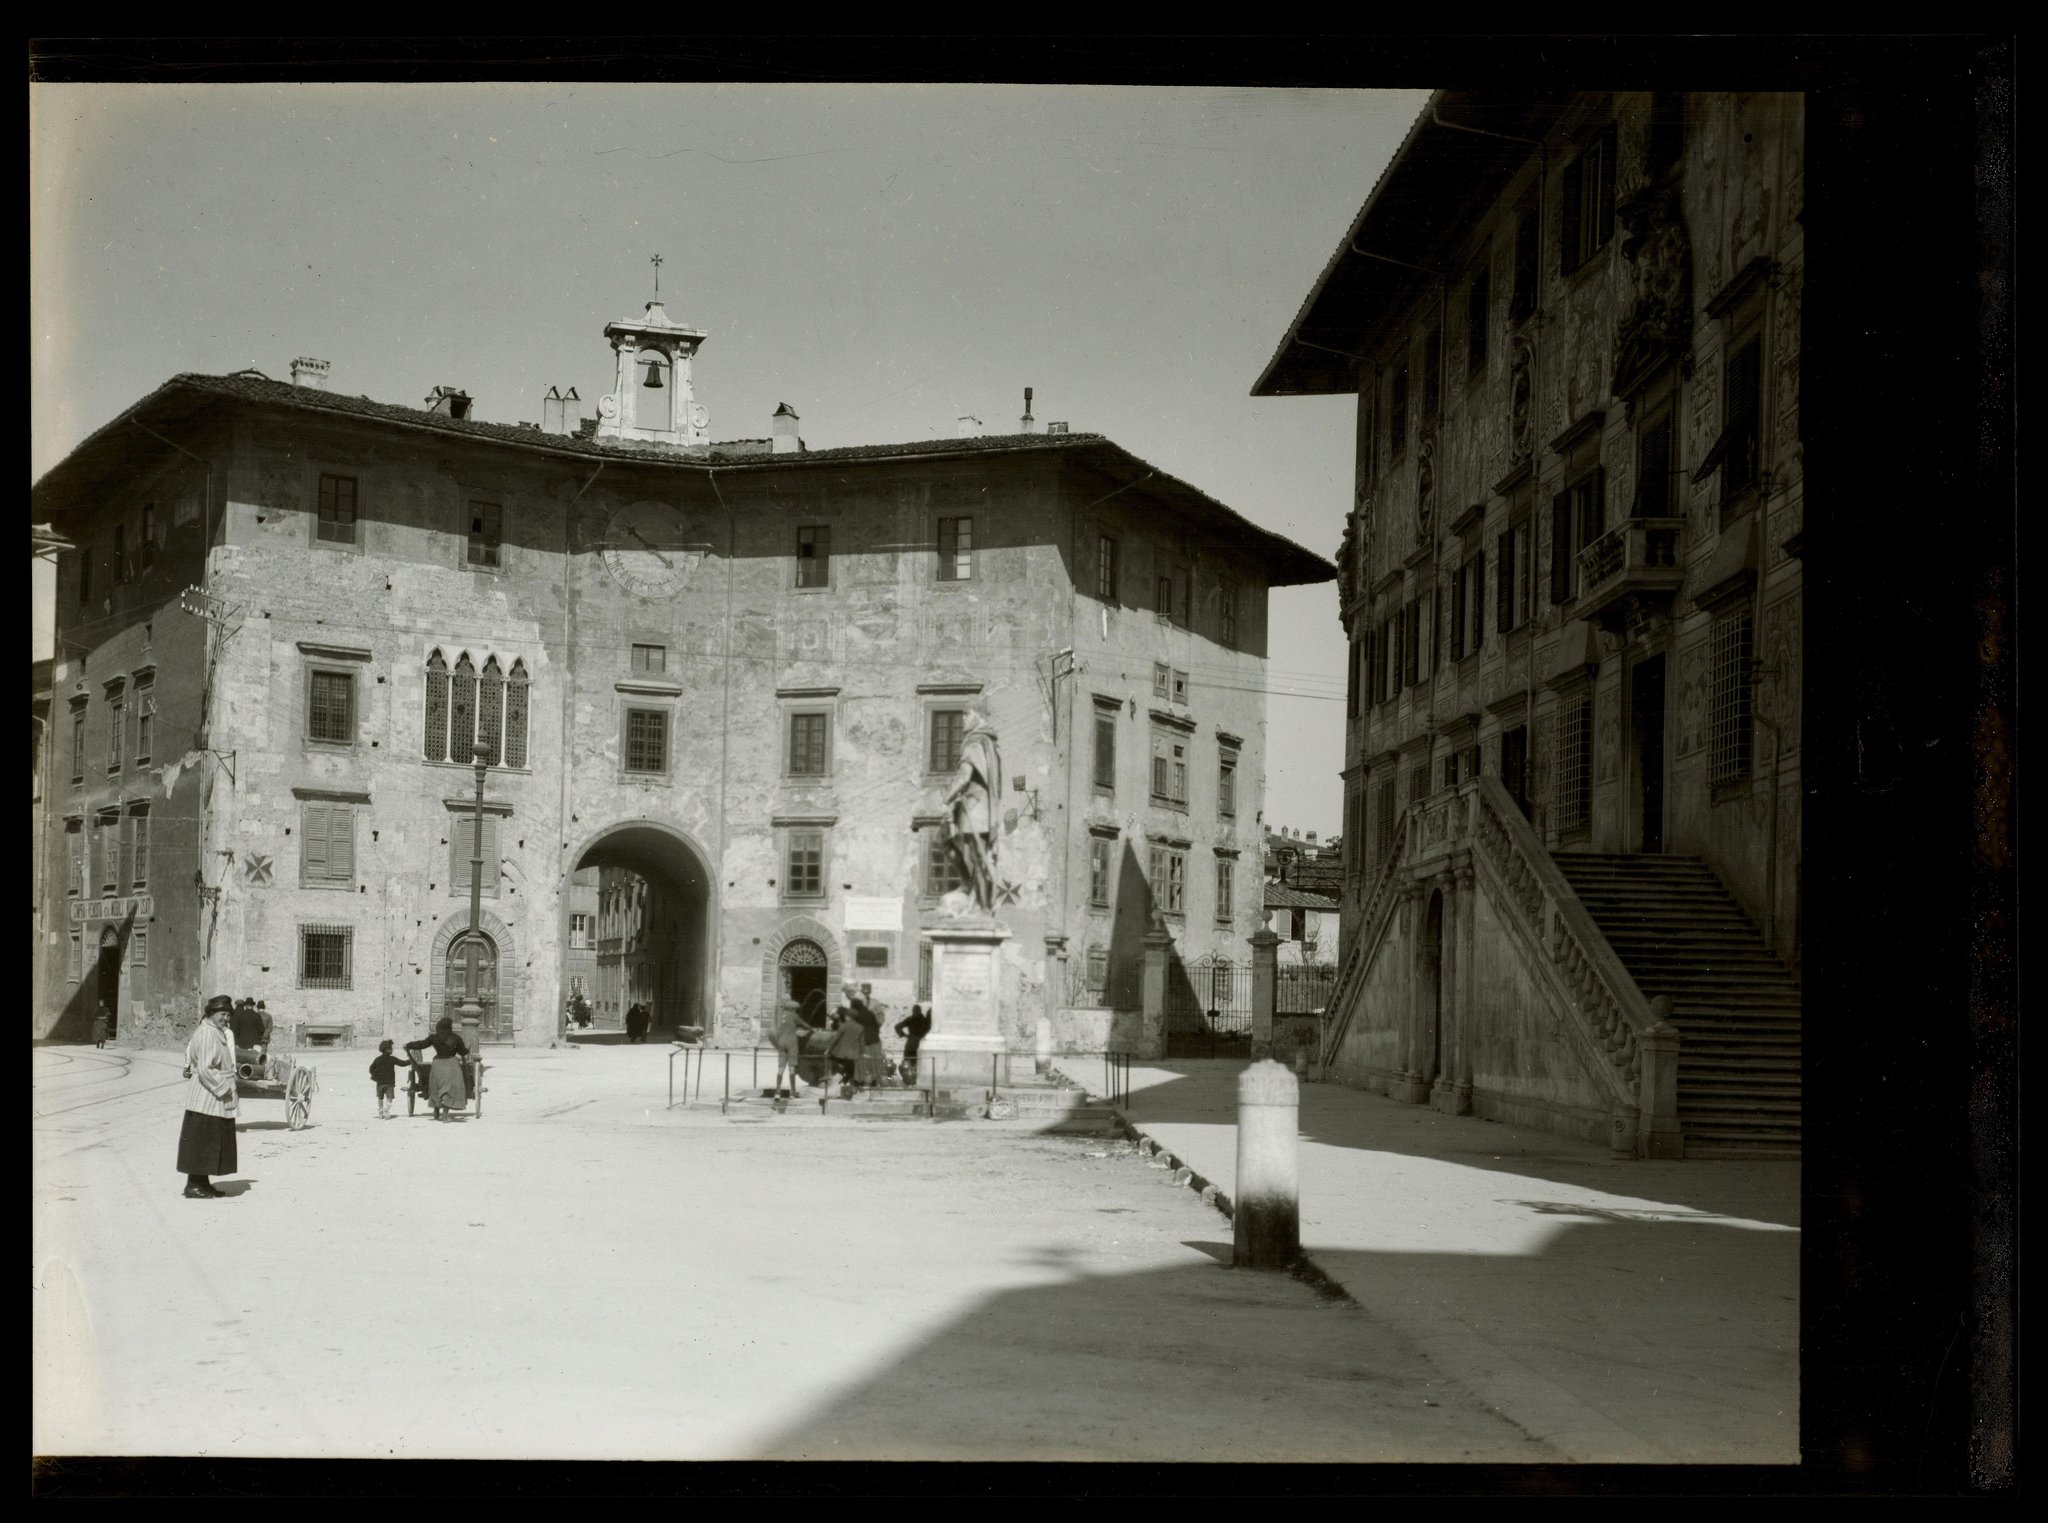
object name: negative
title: Filmnegatief met opname van Genua, Pisa, Ravenna of Milaan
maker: Anonymous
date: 1907-1935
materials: film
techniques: gelatin silver negative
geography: italy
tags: italy